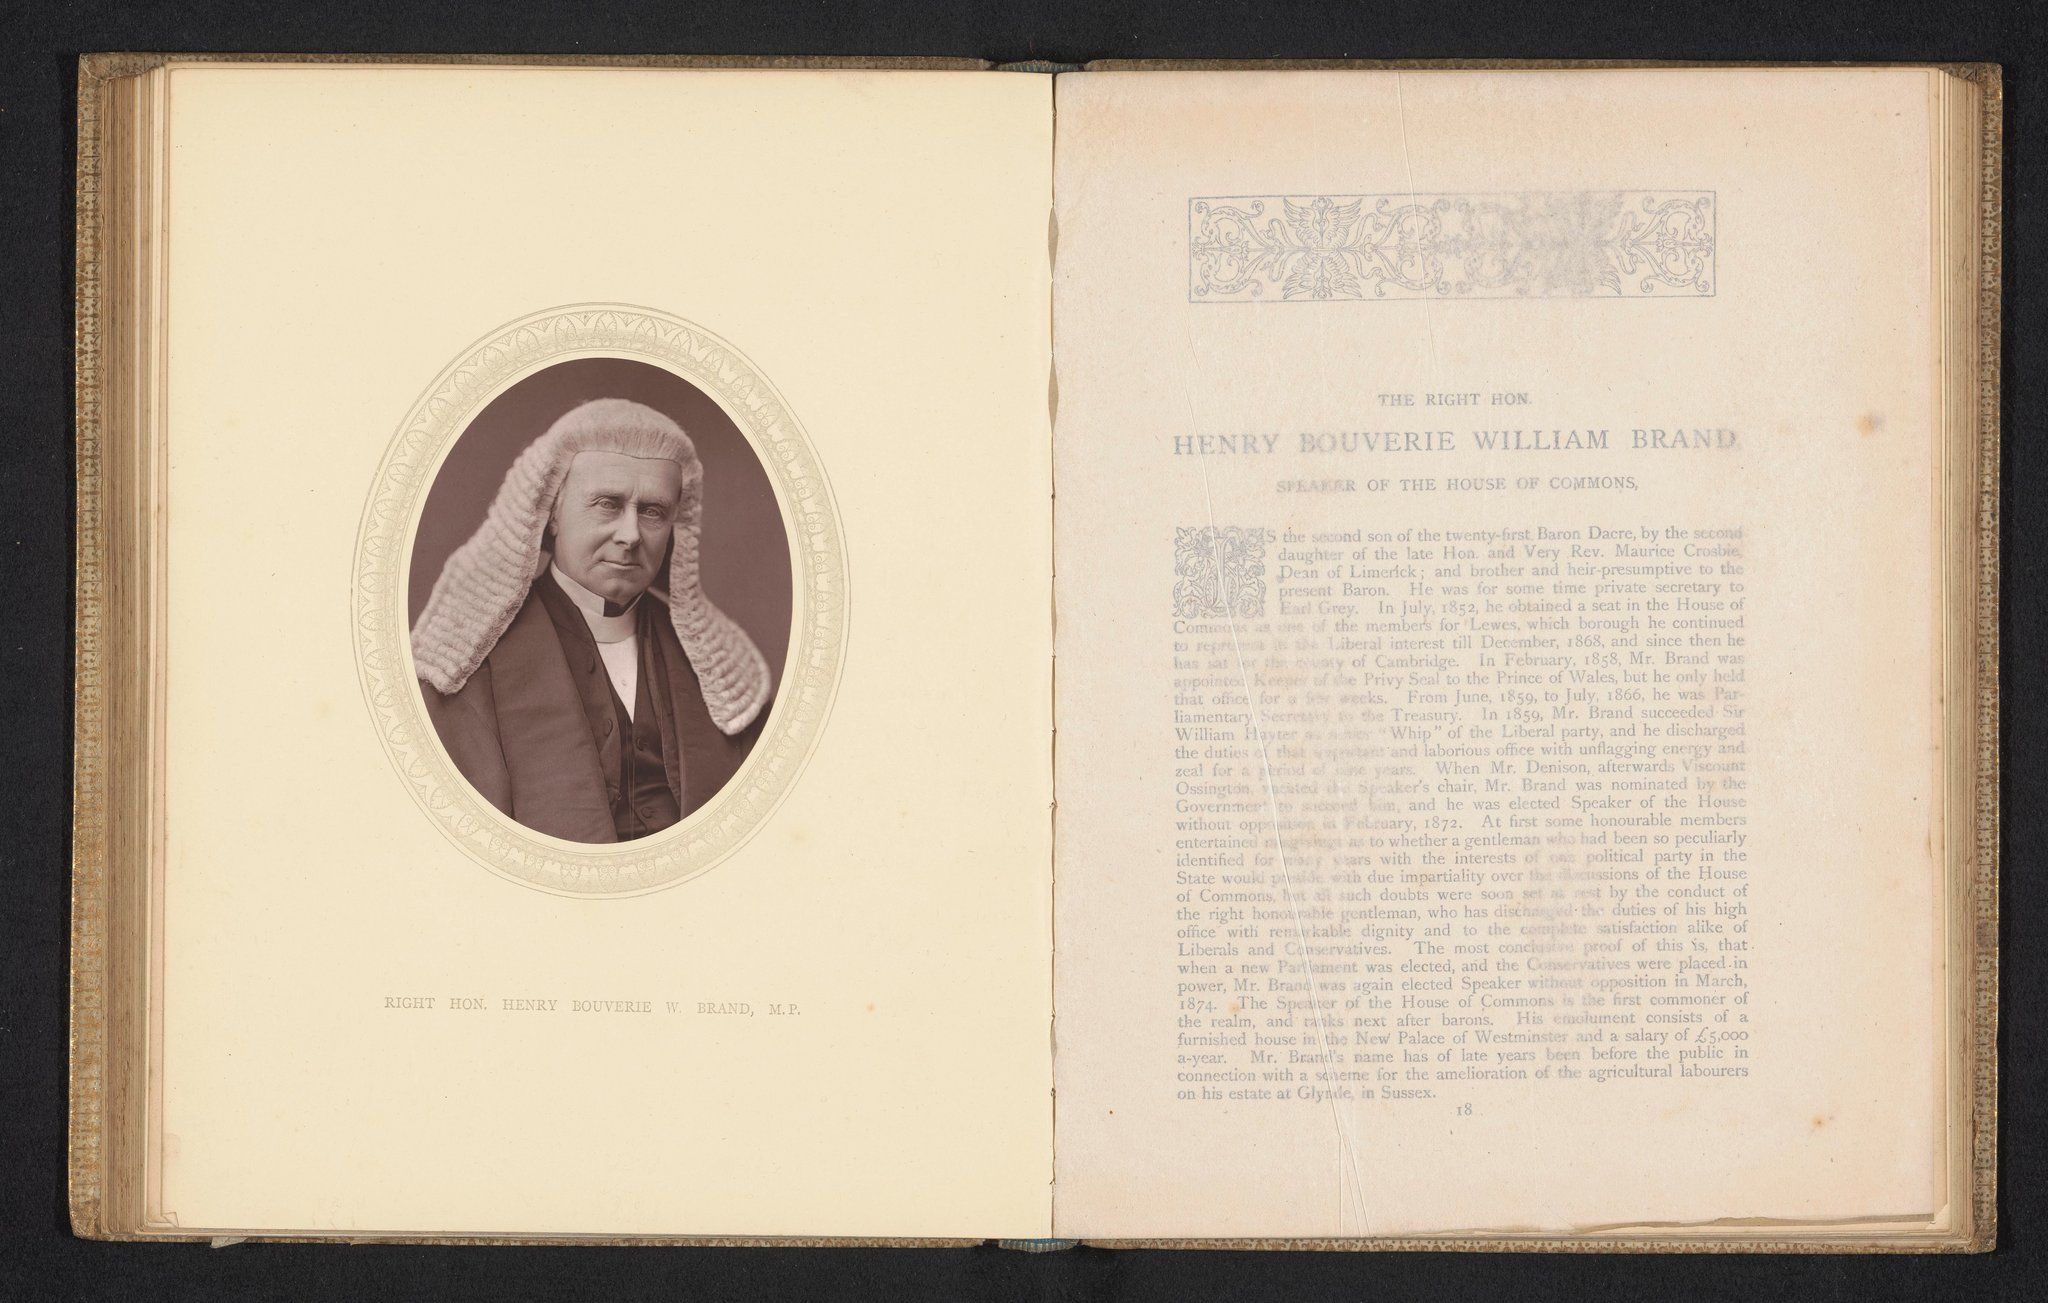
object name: page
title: Right hon. Henry Bouverie W. Brand M.P.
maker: Anonymous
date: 1871-1876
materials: paper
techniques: woodburytype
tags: historical persons (portraits and scenes from the life) (+ (full) bust portrait), politician, e.g. party leader